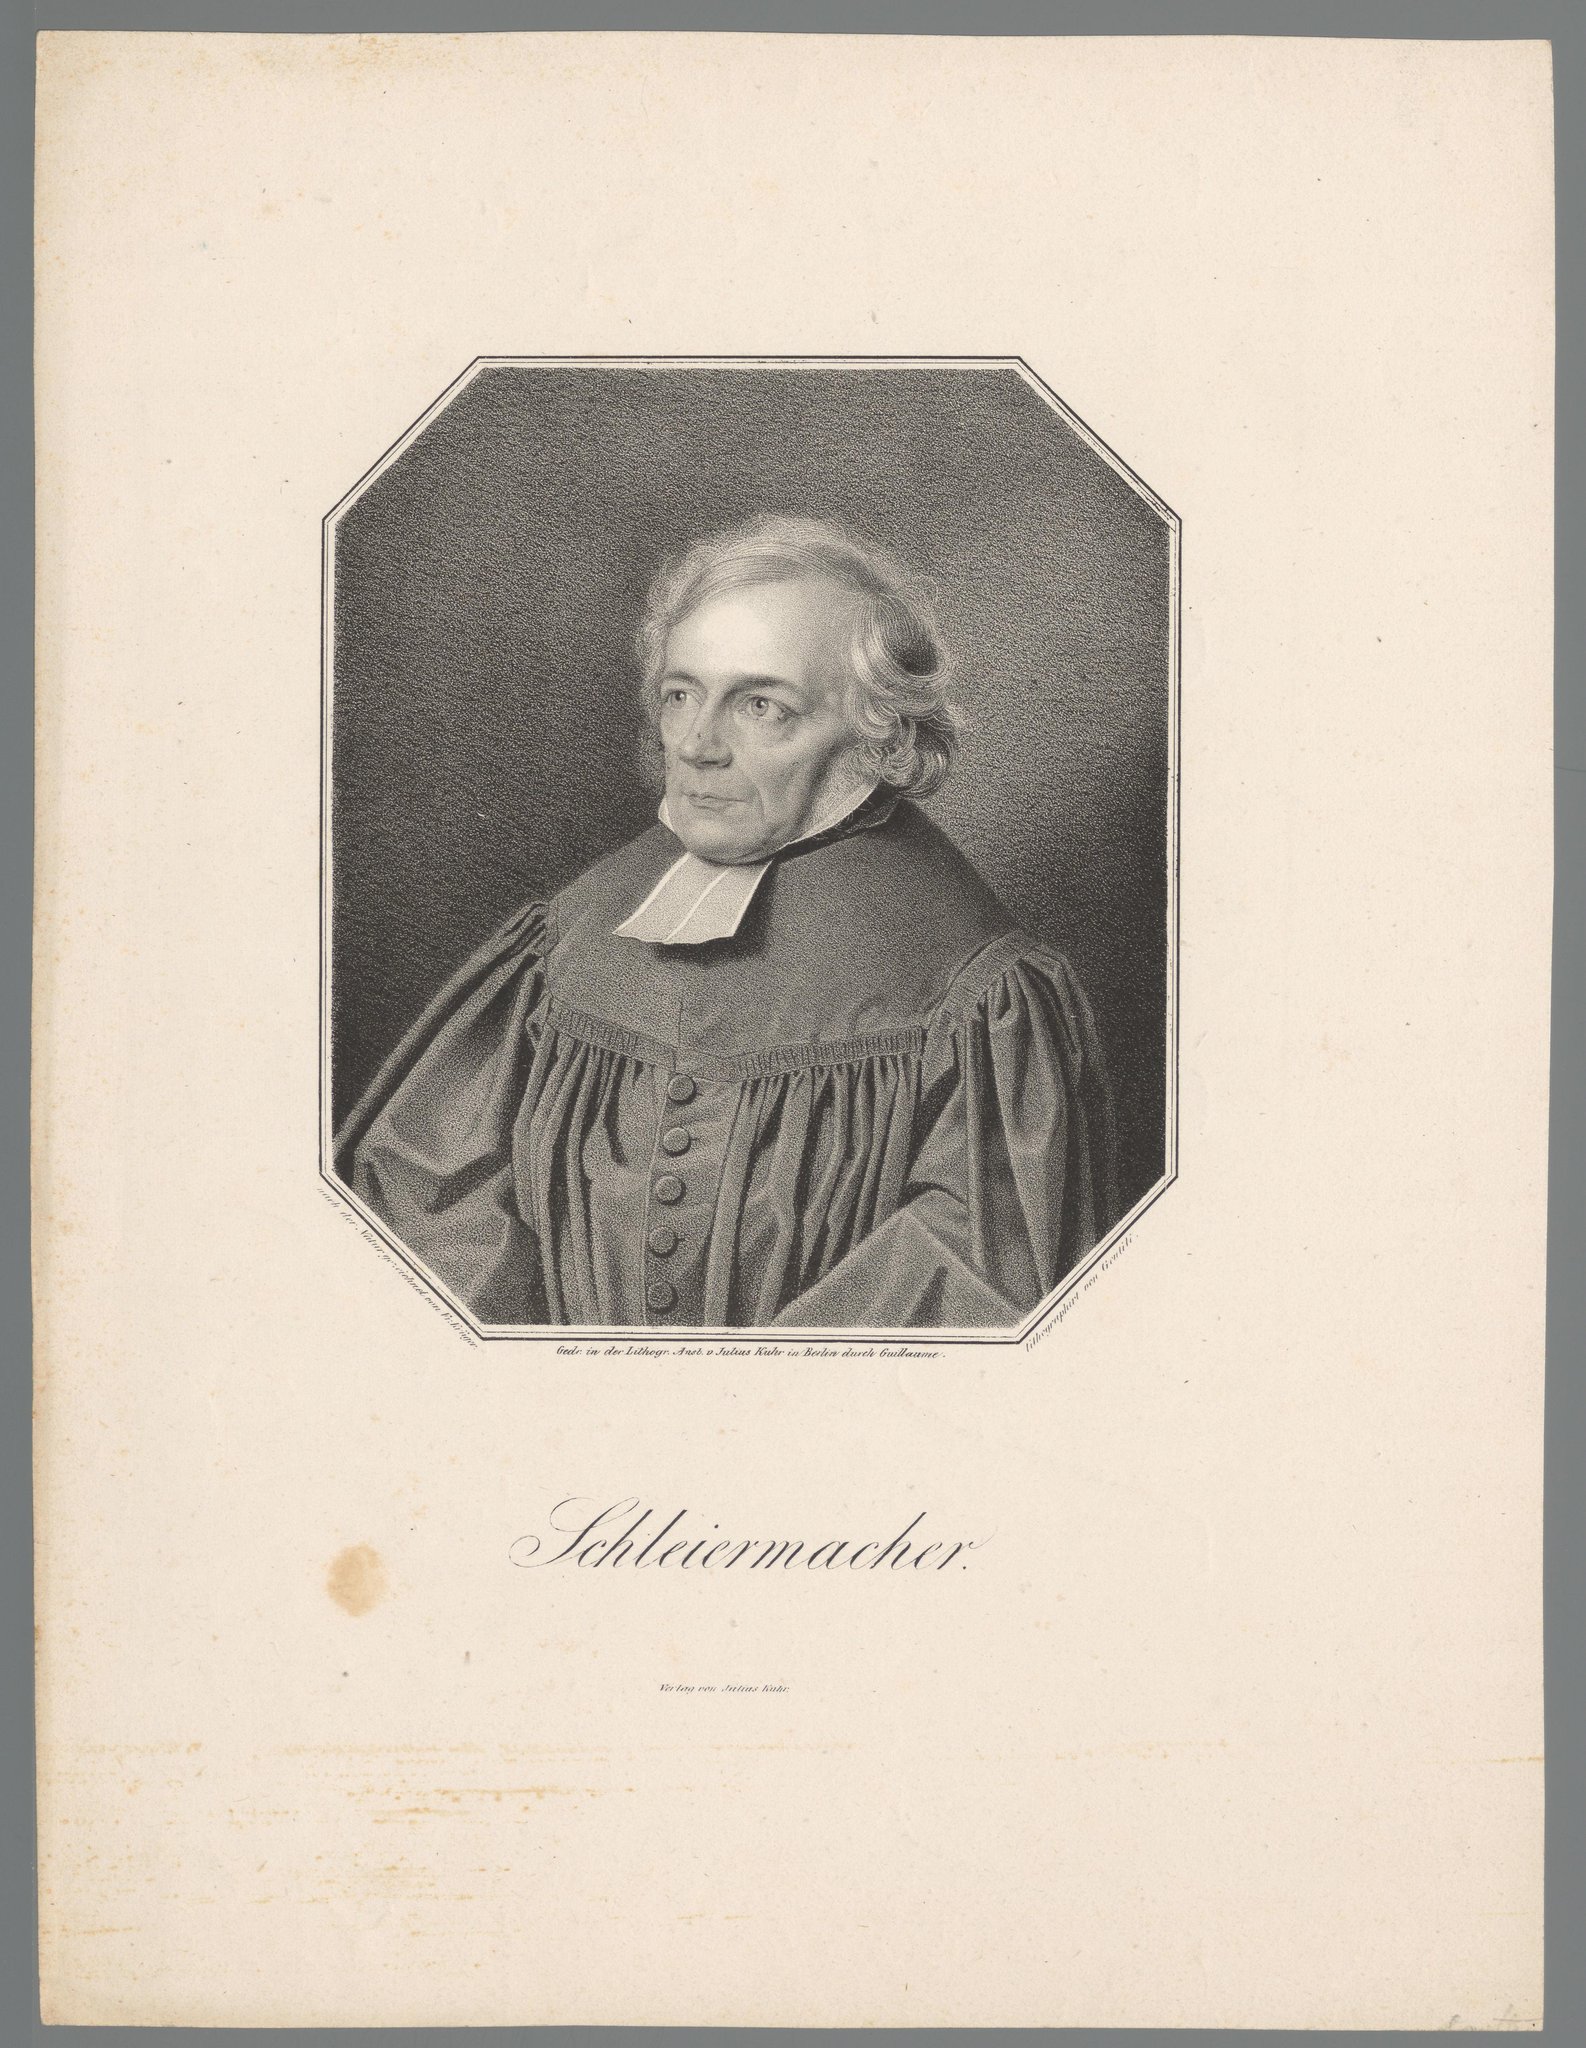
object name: print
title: Portret van Friedrich Ernst Daniel Schleiermacher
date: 1826-1840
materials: paper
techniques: lithograph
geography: berlin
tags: berlin, theologian, historical persons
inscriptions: collector's mark: Lugt 2228